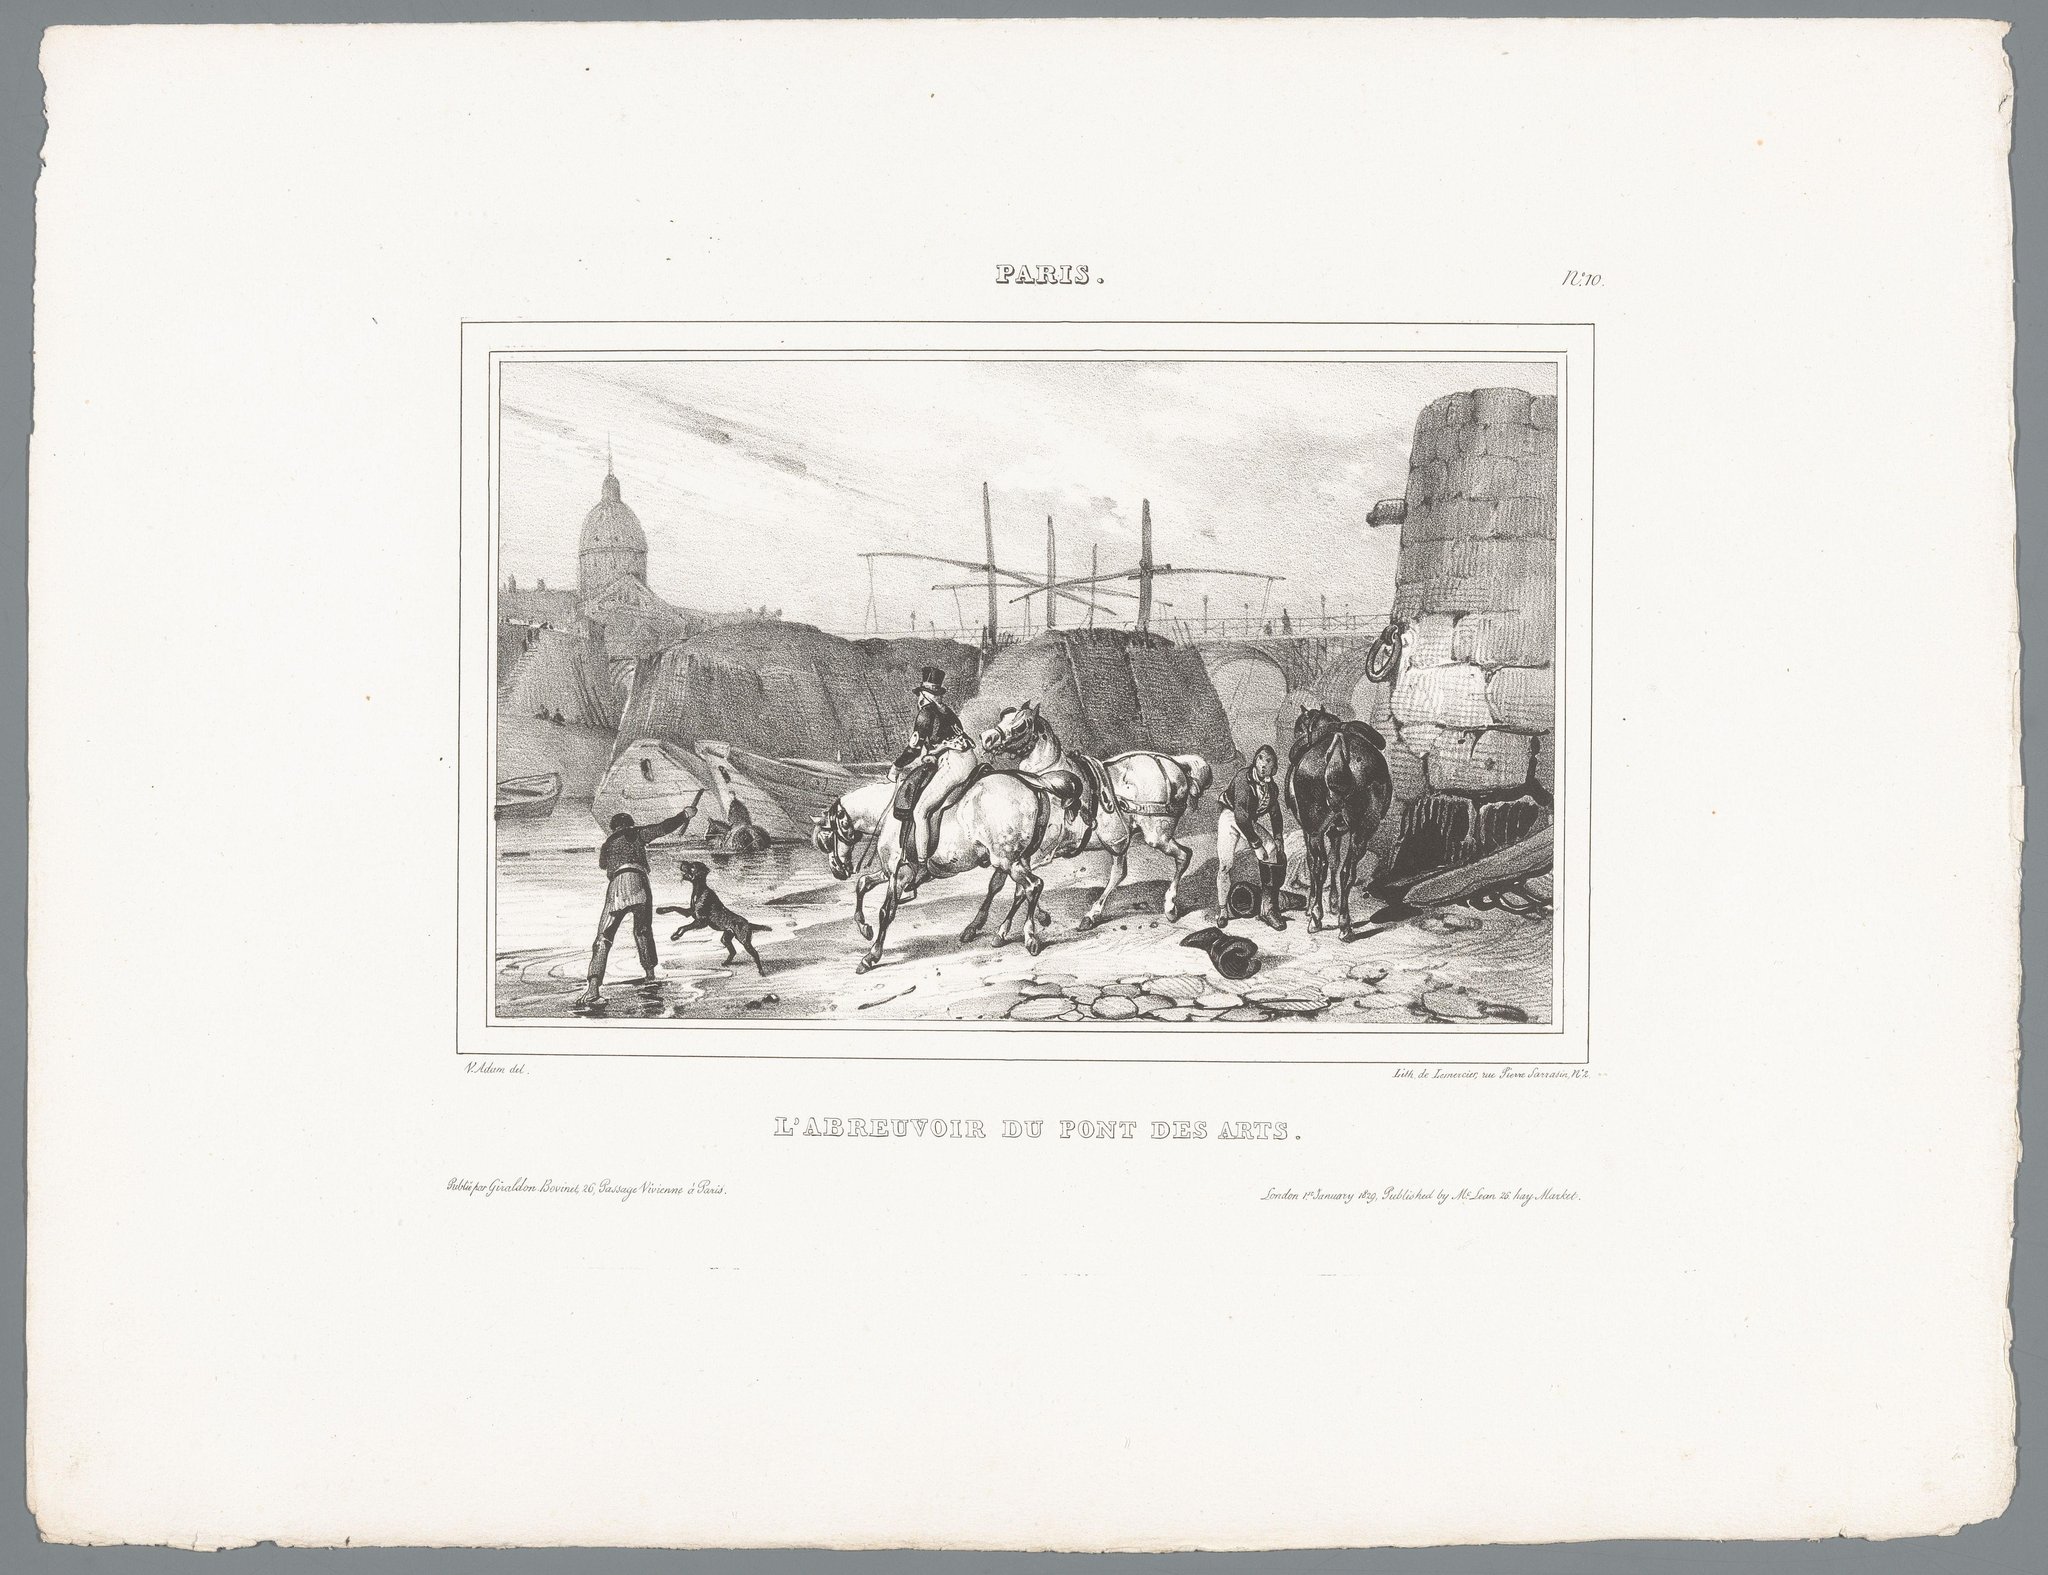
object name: print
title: Paris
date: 1829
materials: paper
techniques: lithograph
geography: paris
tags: trough, river, horse, bridge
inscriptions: collector's mark: Lugt 2228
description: Twee ruiters laten hun paarden drinken bij de Pont des Arts in Parijs.